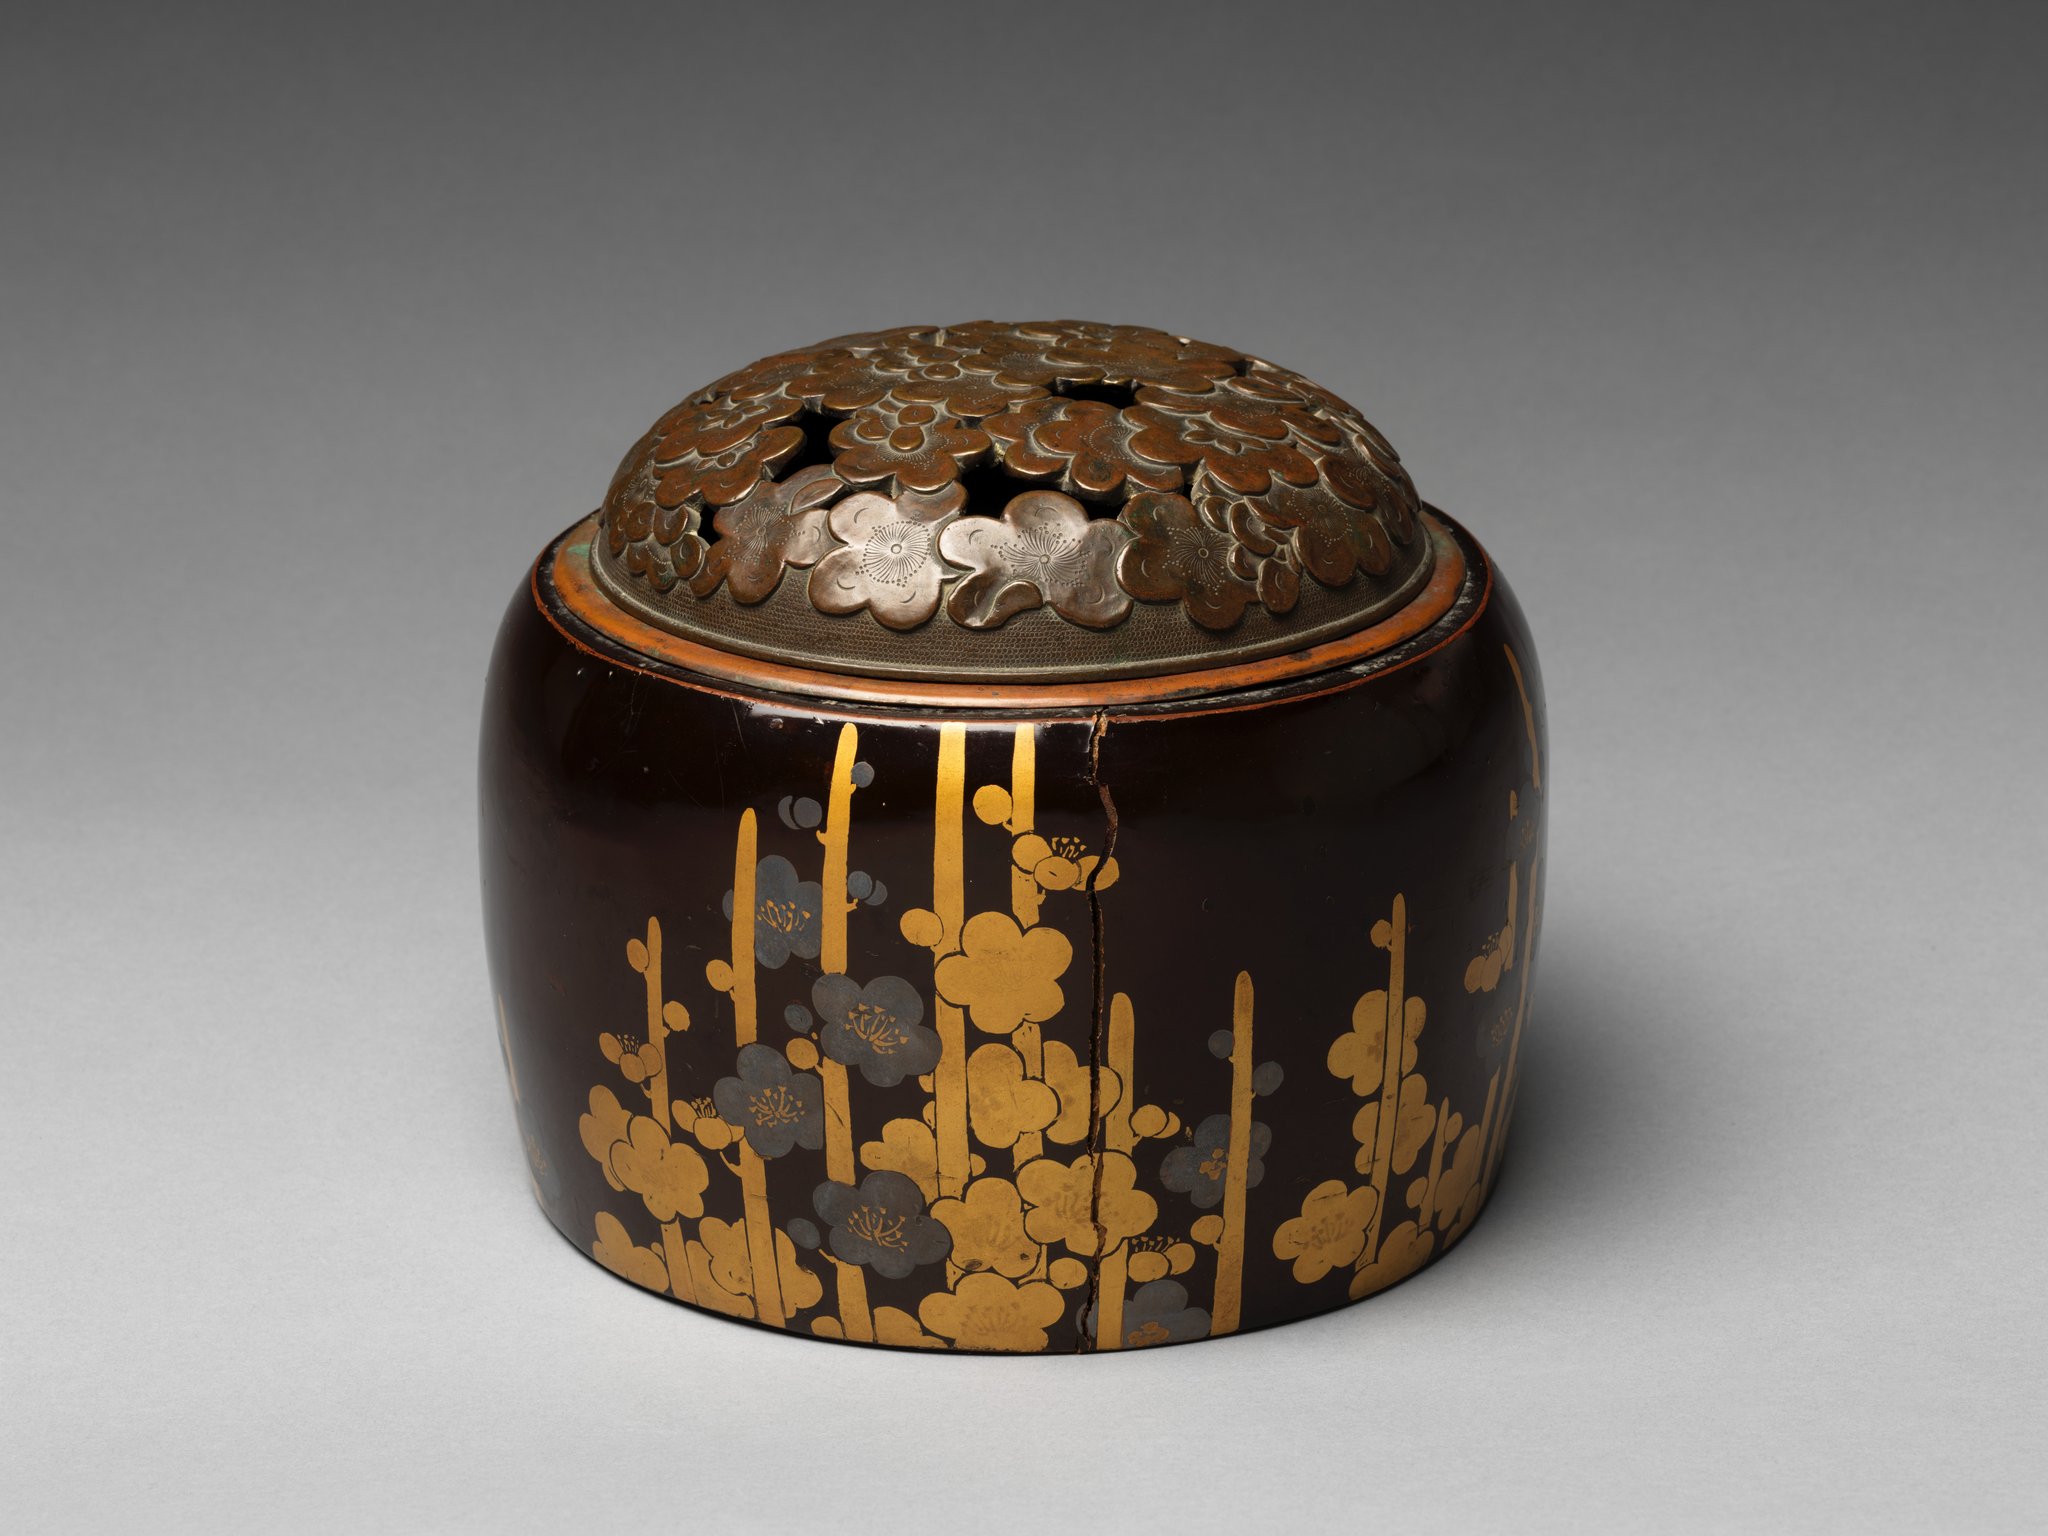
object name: handwarmer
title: Handwarmer with decoration of plum blossoms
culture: japanese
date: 1701-1800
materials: bronze, gold, lacquer, silver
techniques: maki